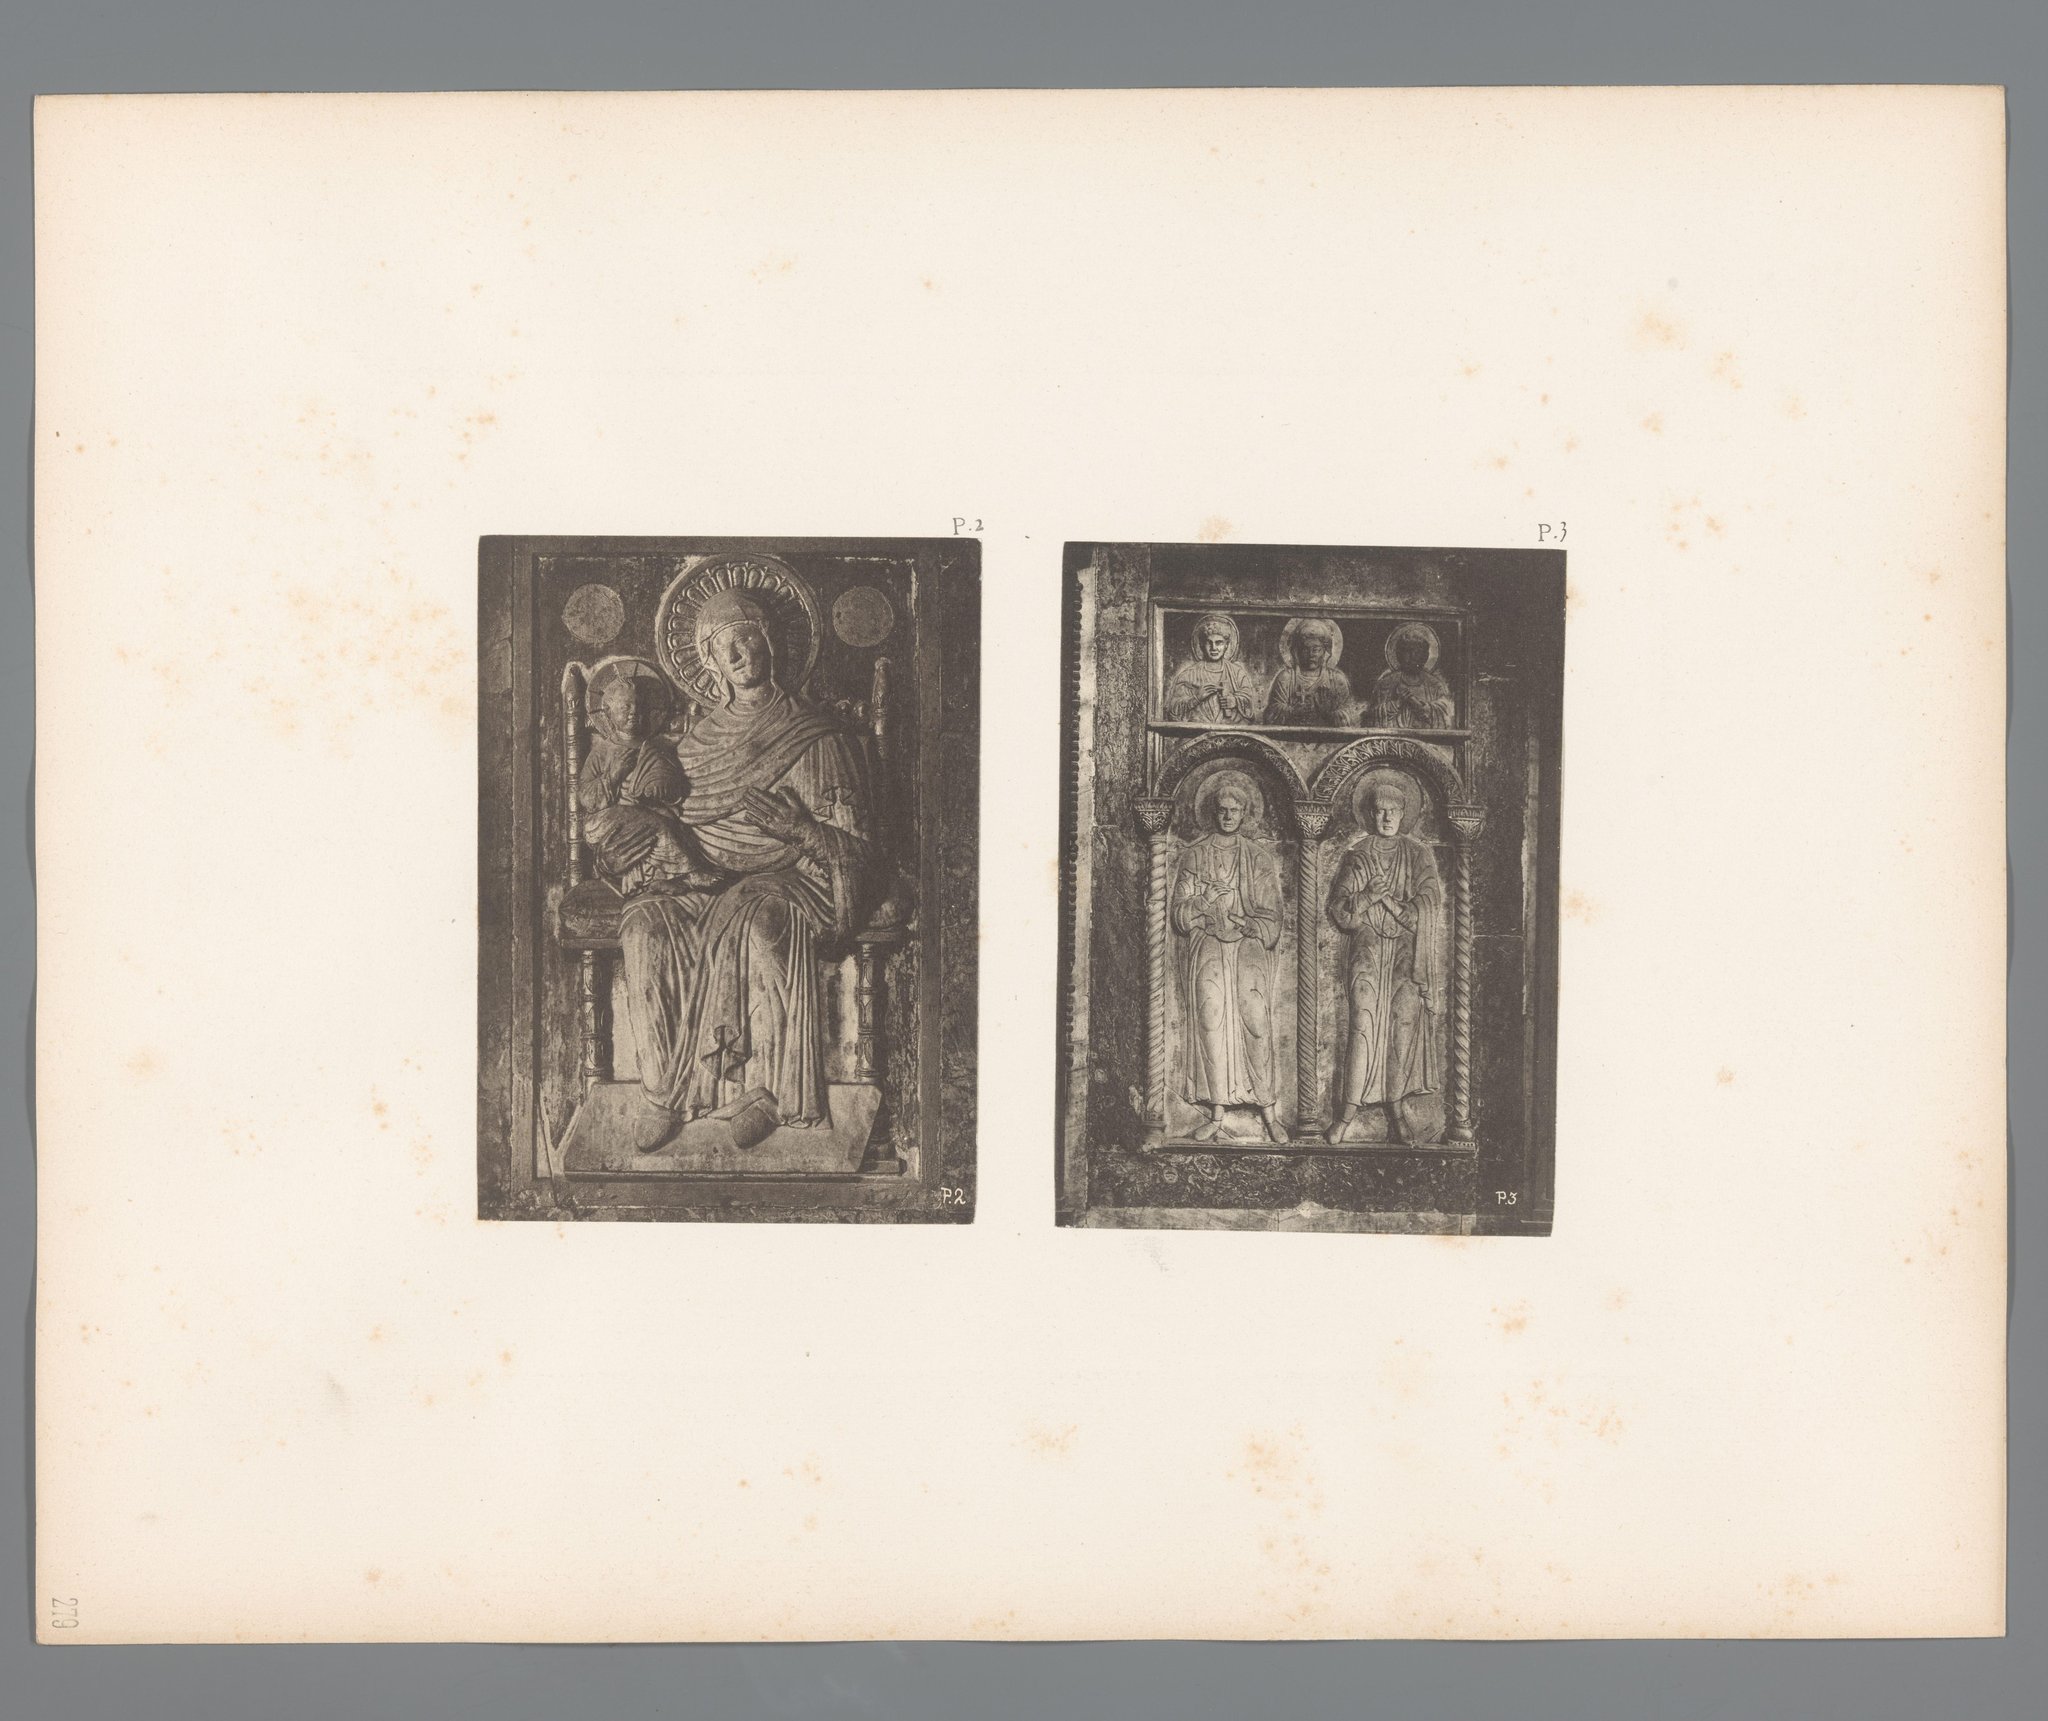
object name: photomechanical print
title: Twee afbeeldingen van reliëfs van Maria met Christus en heiligen in de San Marco in Venetië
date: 1880-1885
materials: paper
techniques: photograph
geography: st. mark's basilica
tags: madonna: mary sitting or enthroned, the christ-child in her lap (or in front of her bosom) (mary sometimes represented half-length), saints, piece of sculpture, reproduction of a piece of sculpture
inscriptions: number: ‘P.3’, number: ‘P.2’, number: ‘279’, number: ‘P.3’, number: ‘P.2’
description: Deze prenten maken deel uit van een omslag met 58 prenten op 50 bladen.